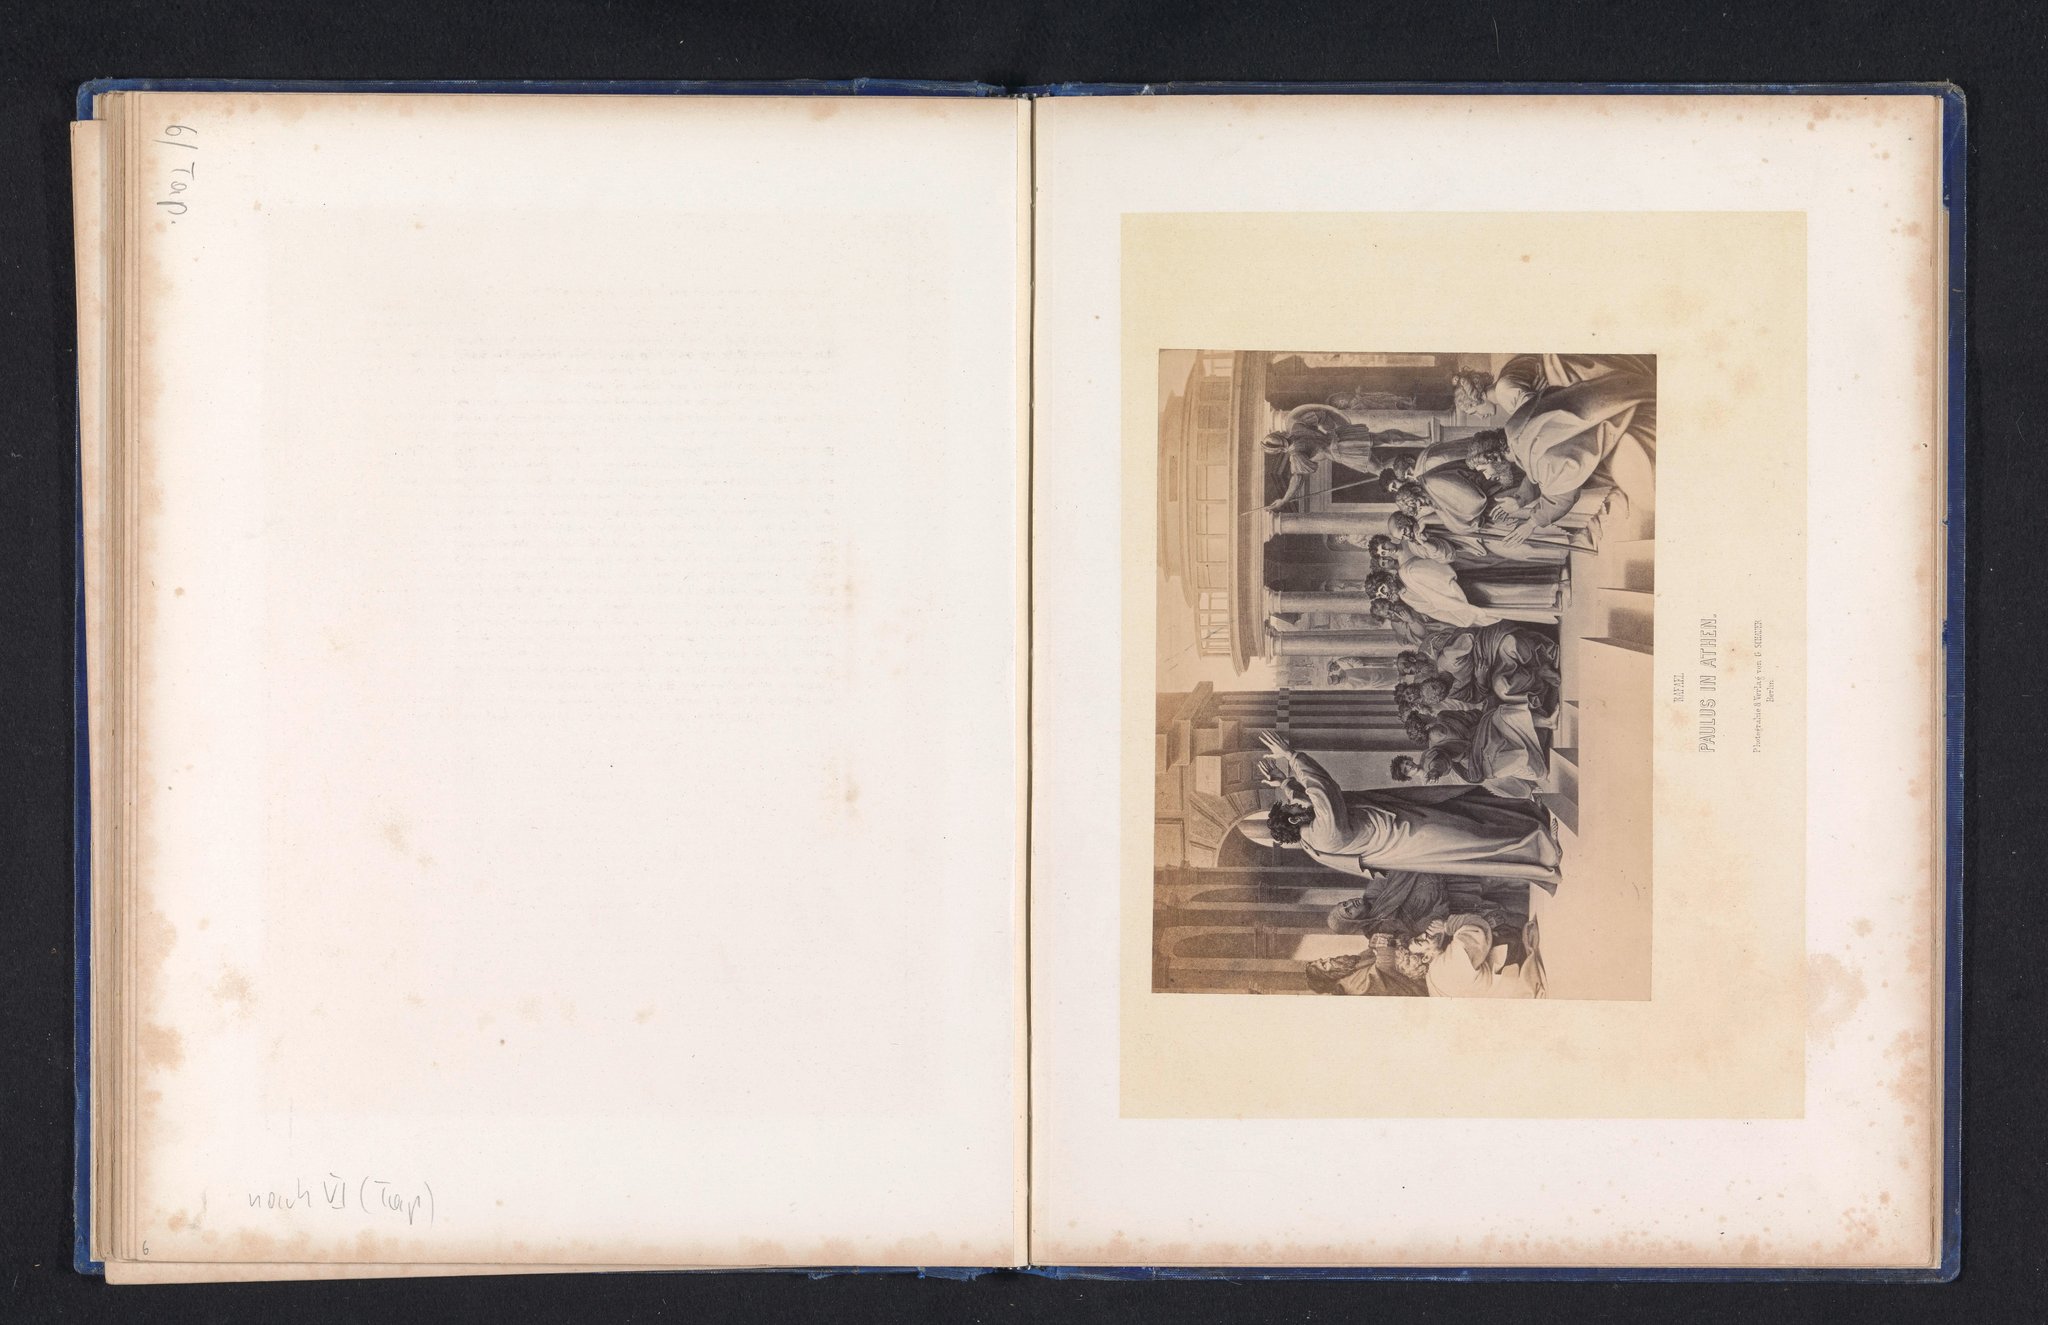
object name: reproduction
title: Rafael, Paulus in Athen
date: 1851-1861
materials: photographic support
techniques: albumen print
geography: berlin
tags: paul in athens: on the areopagus he discusses with philosophers (in front of the temple of mars)